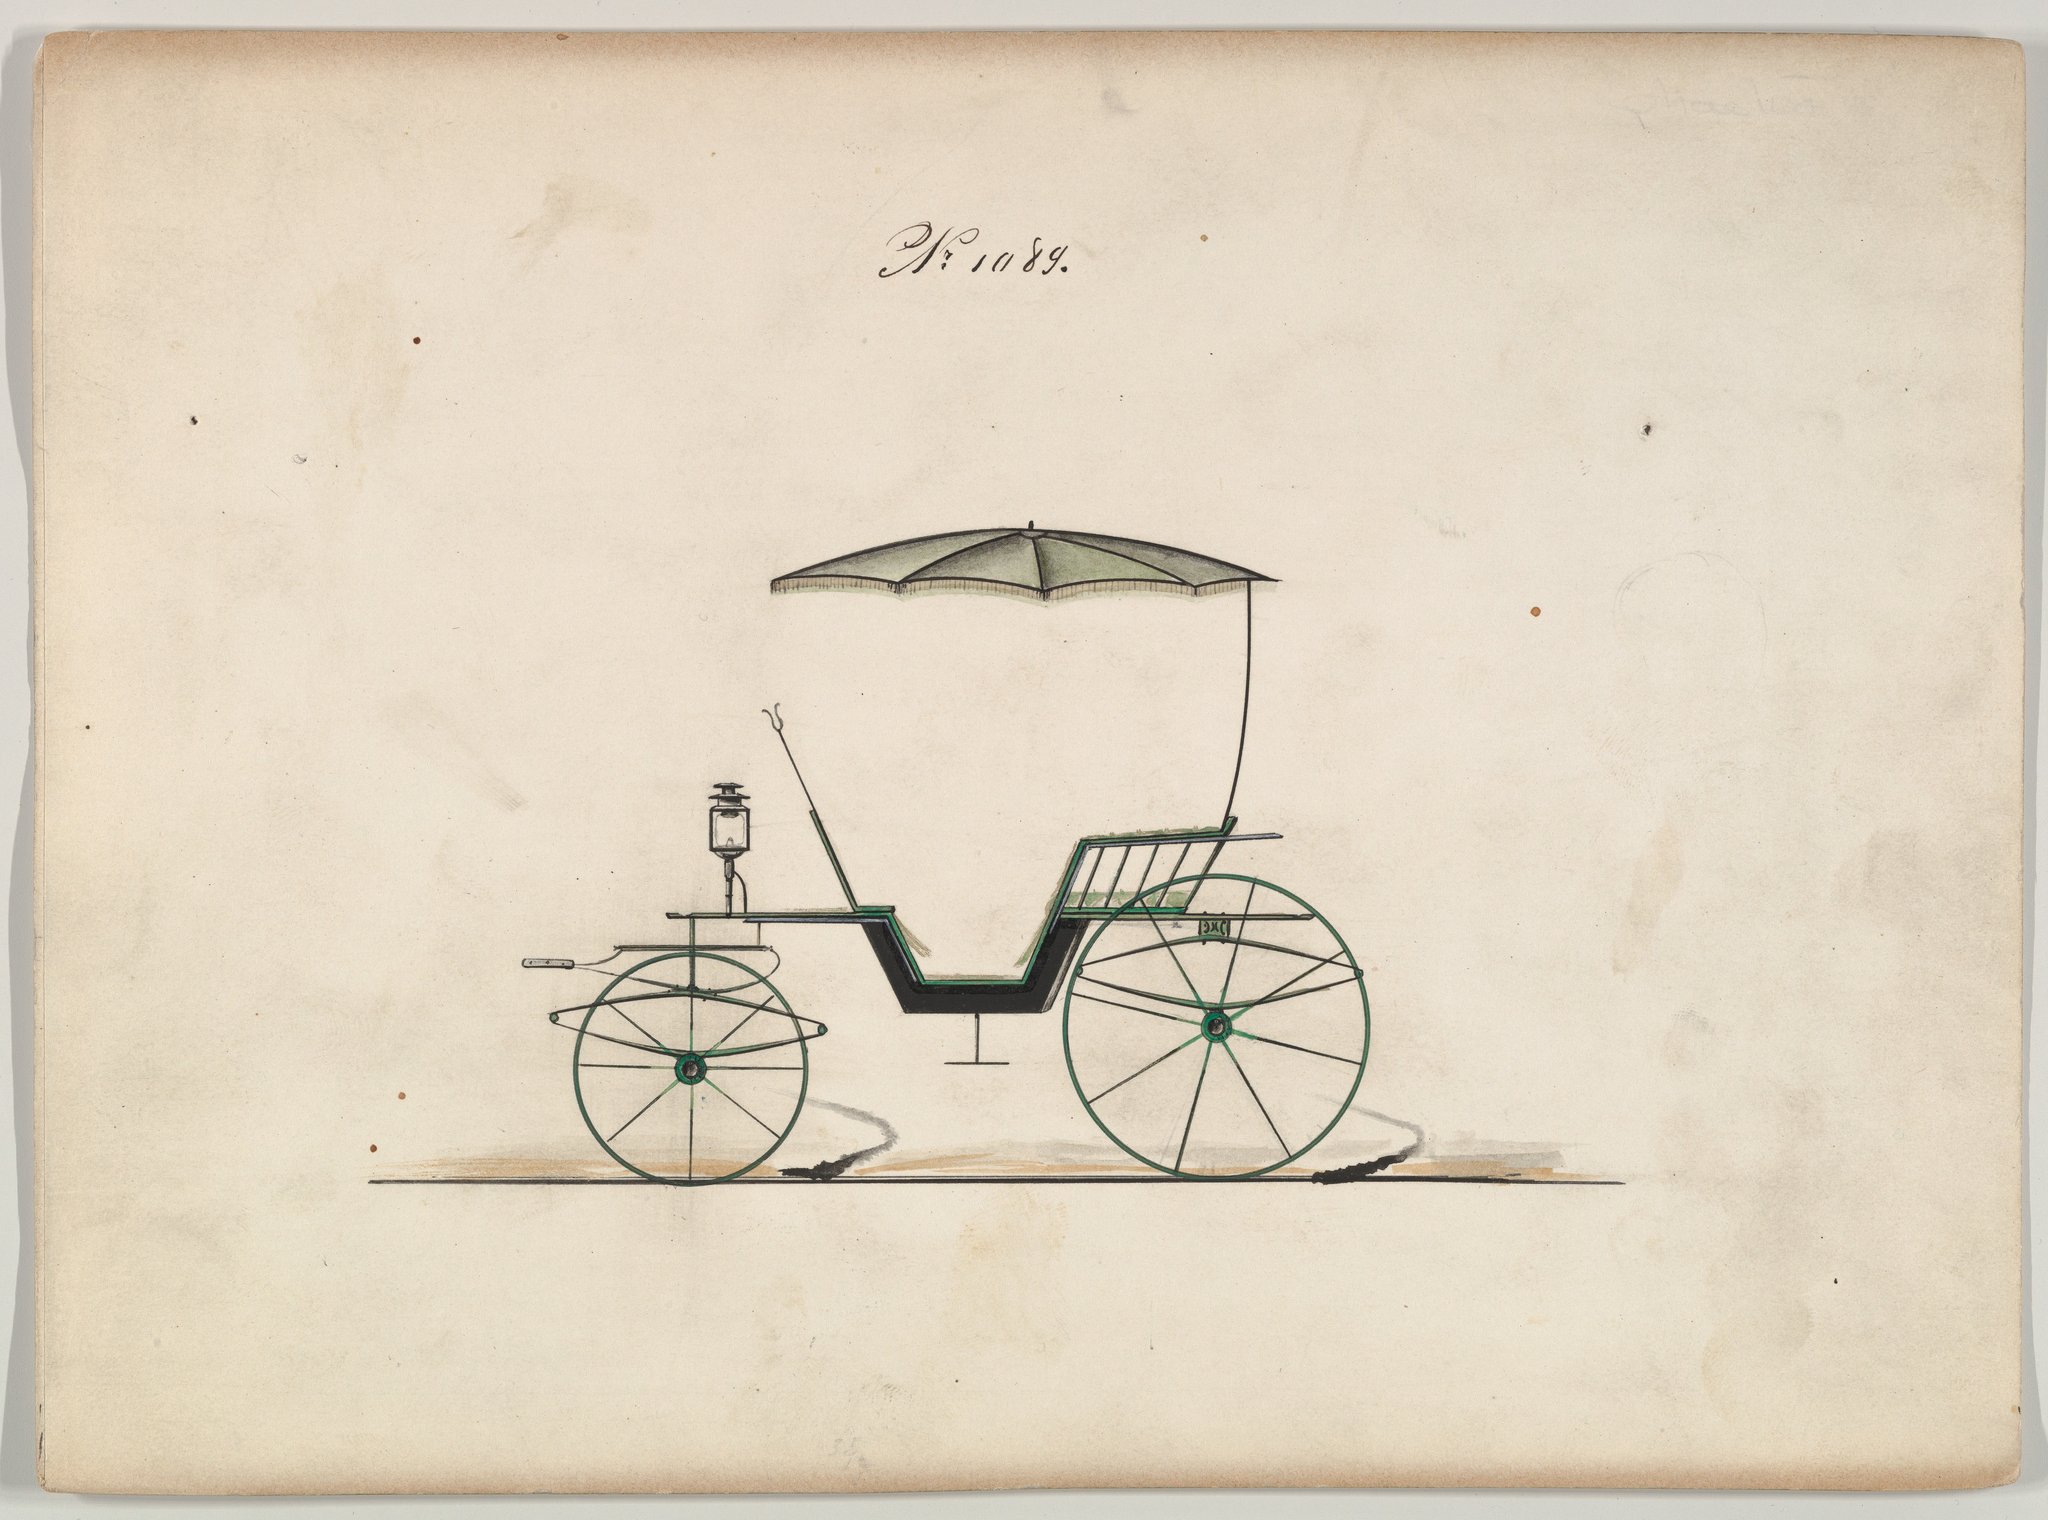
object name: drawing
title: Design for Unclassified Carriage, no. 1089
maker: brewster & co.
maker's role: manufacturer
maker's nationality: american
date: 1850-1870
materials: gouache, gum arabic, ink, watercolor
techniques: pen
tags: carriages